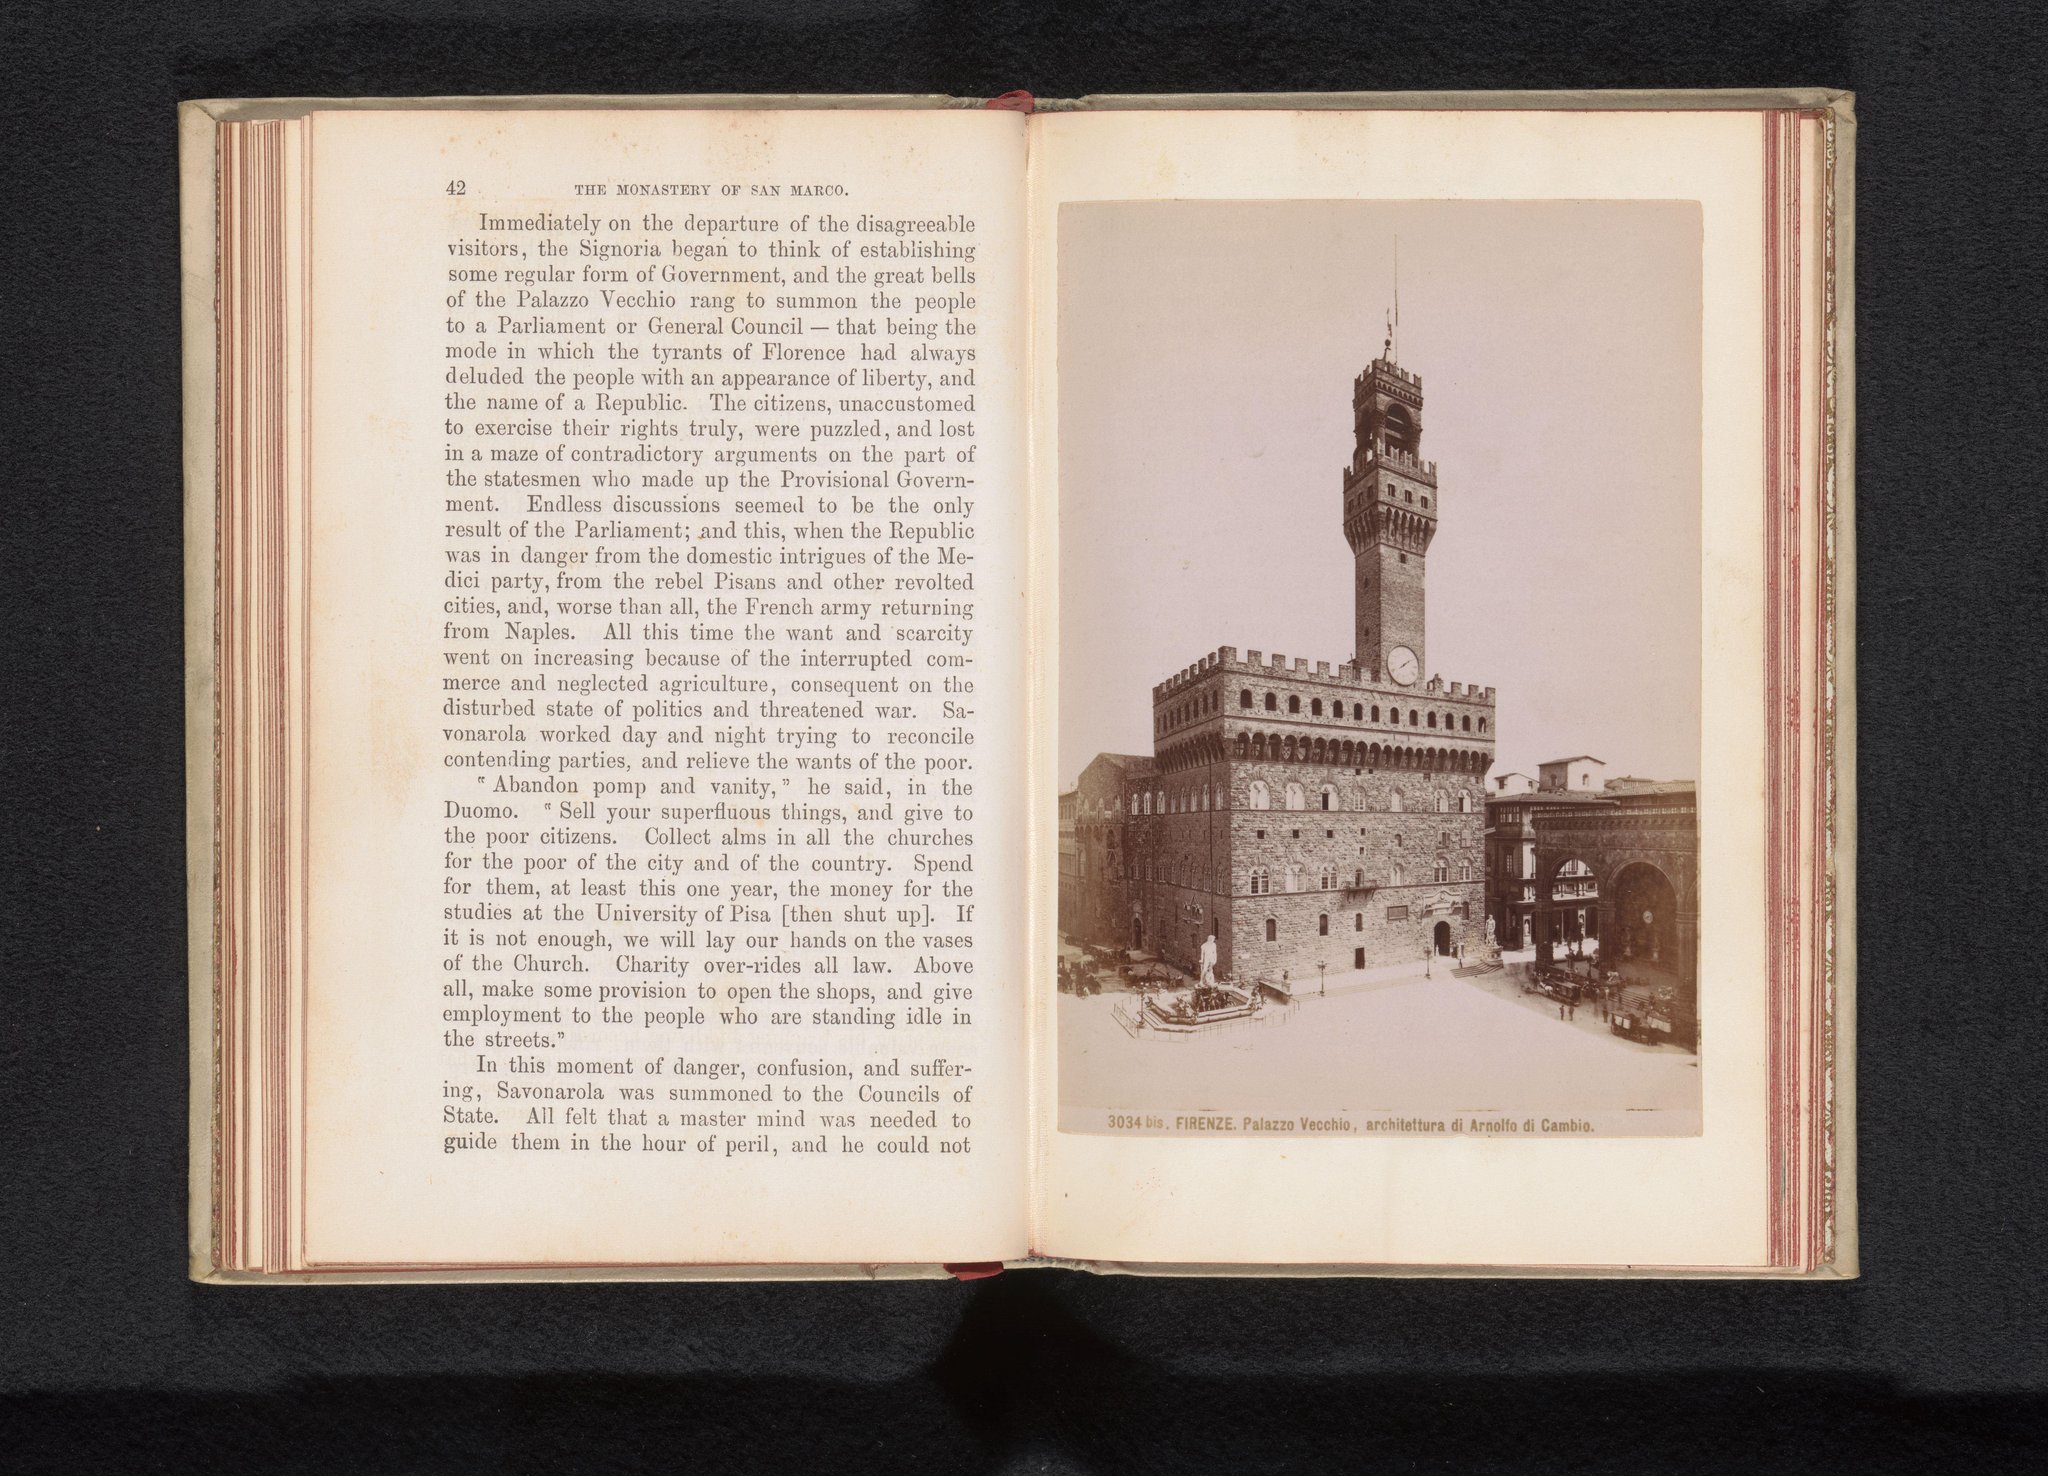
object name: photograph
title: Exterieur van het Palazzo Vecchio te Florence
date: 1878-1888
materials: photographic support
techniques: albumen print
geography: florence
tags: hôtel, i.e. small palace in city, façade (of house or building)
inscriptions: number: ‘3034bis.’